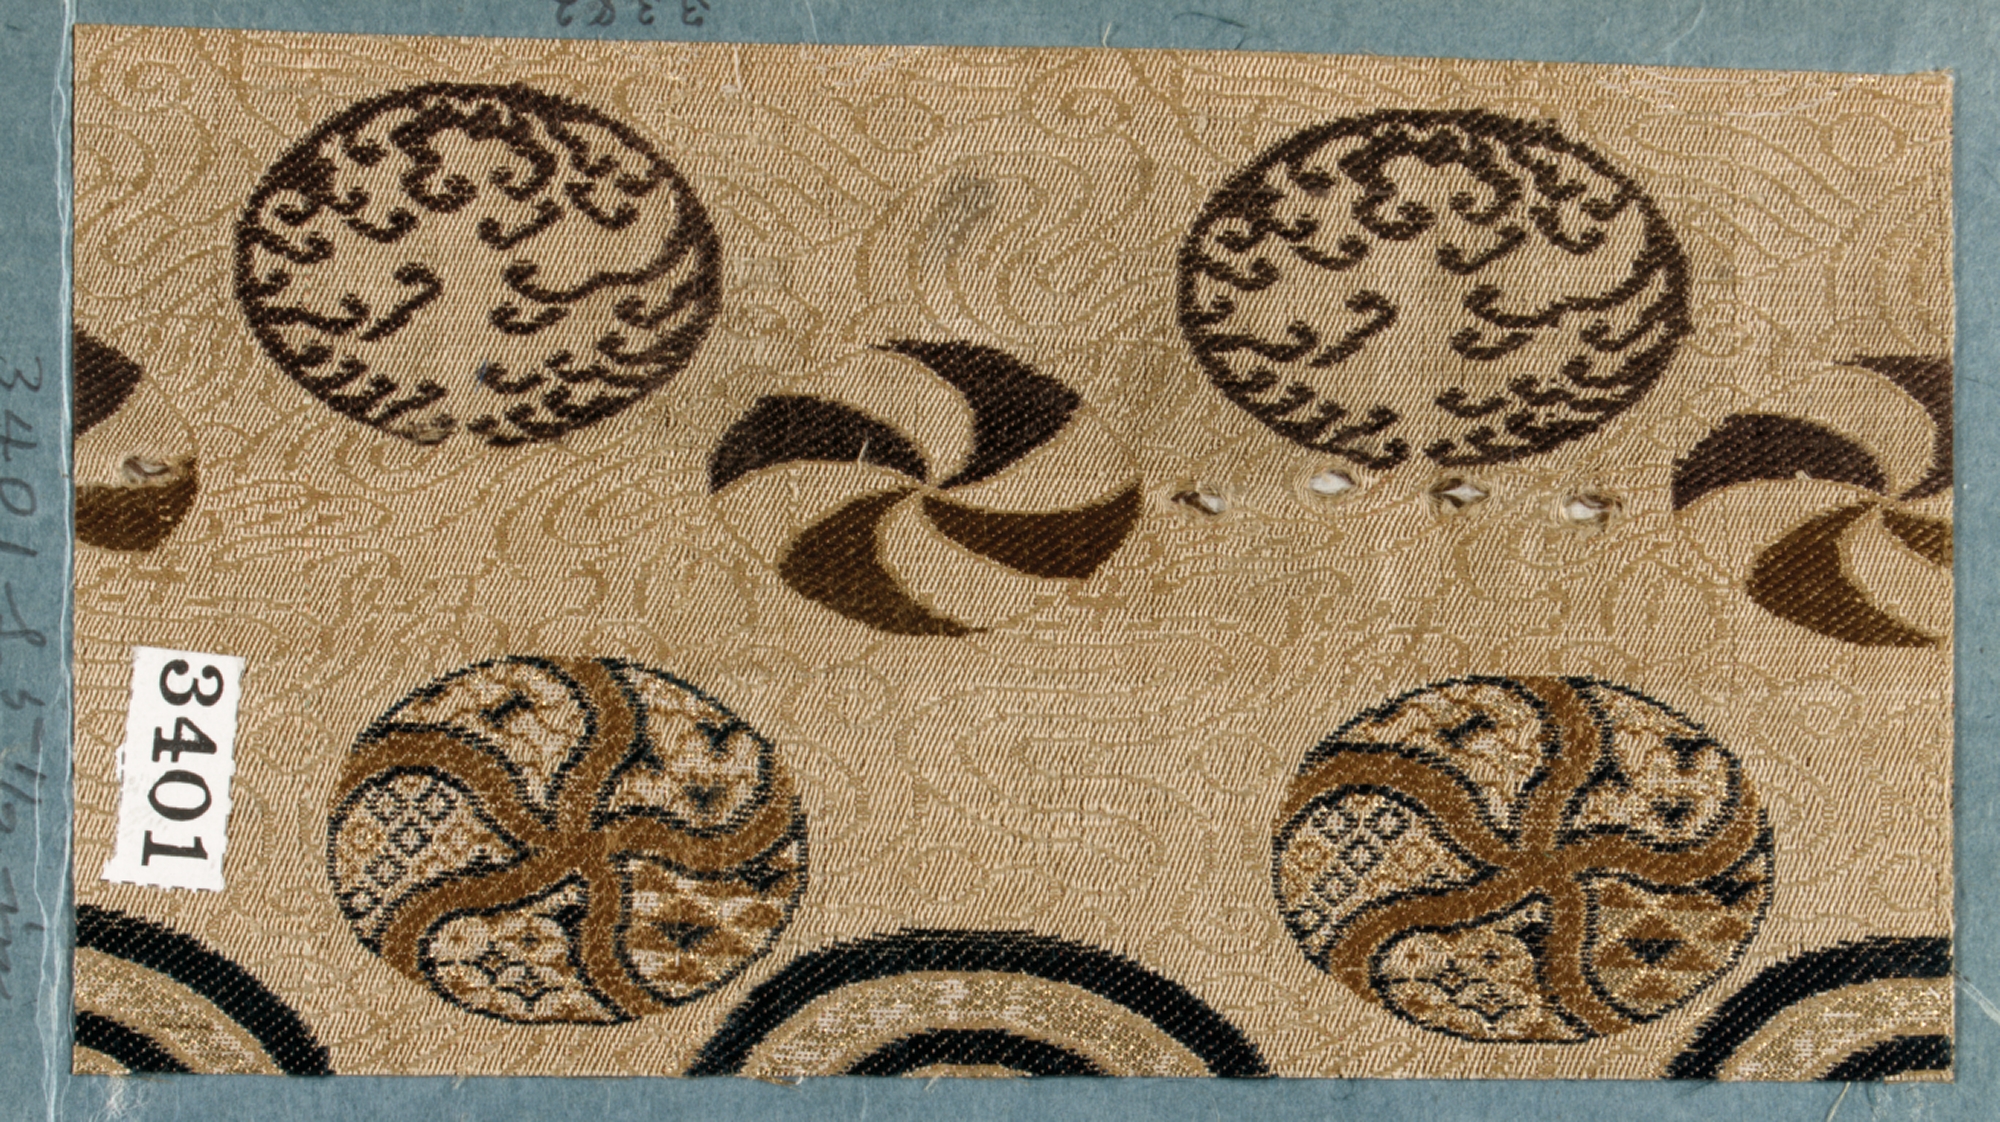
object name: textile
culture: japanese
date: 1801-1900